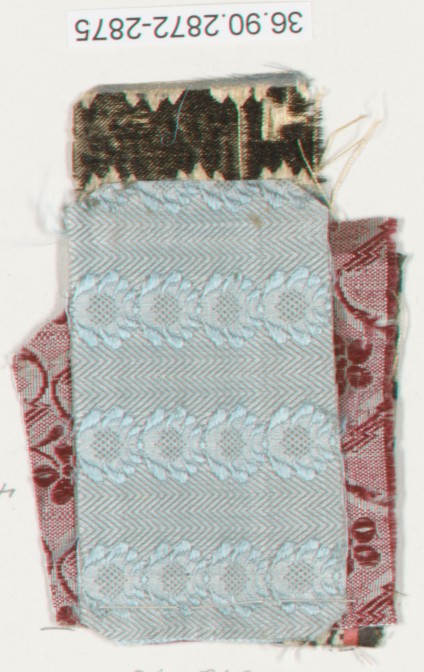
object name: piece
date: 1801-1900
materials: silk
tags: flowers